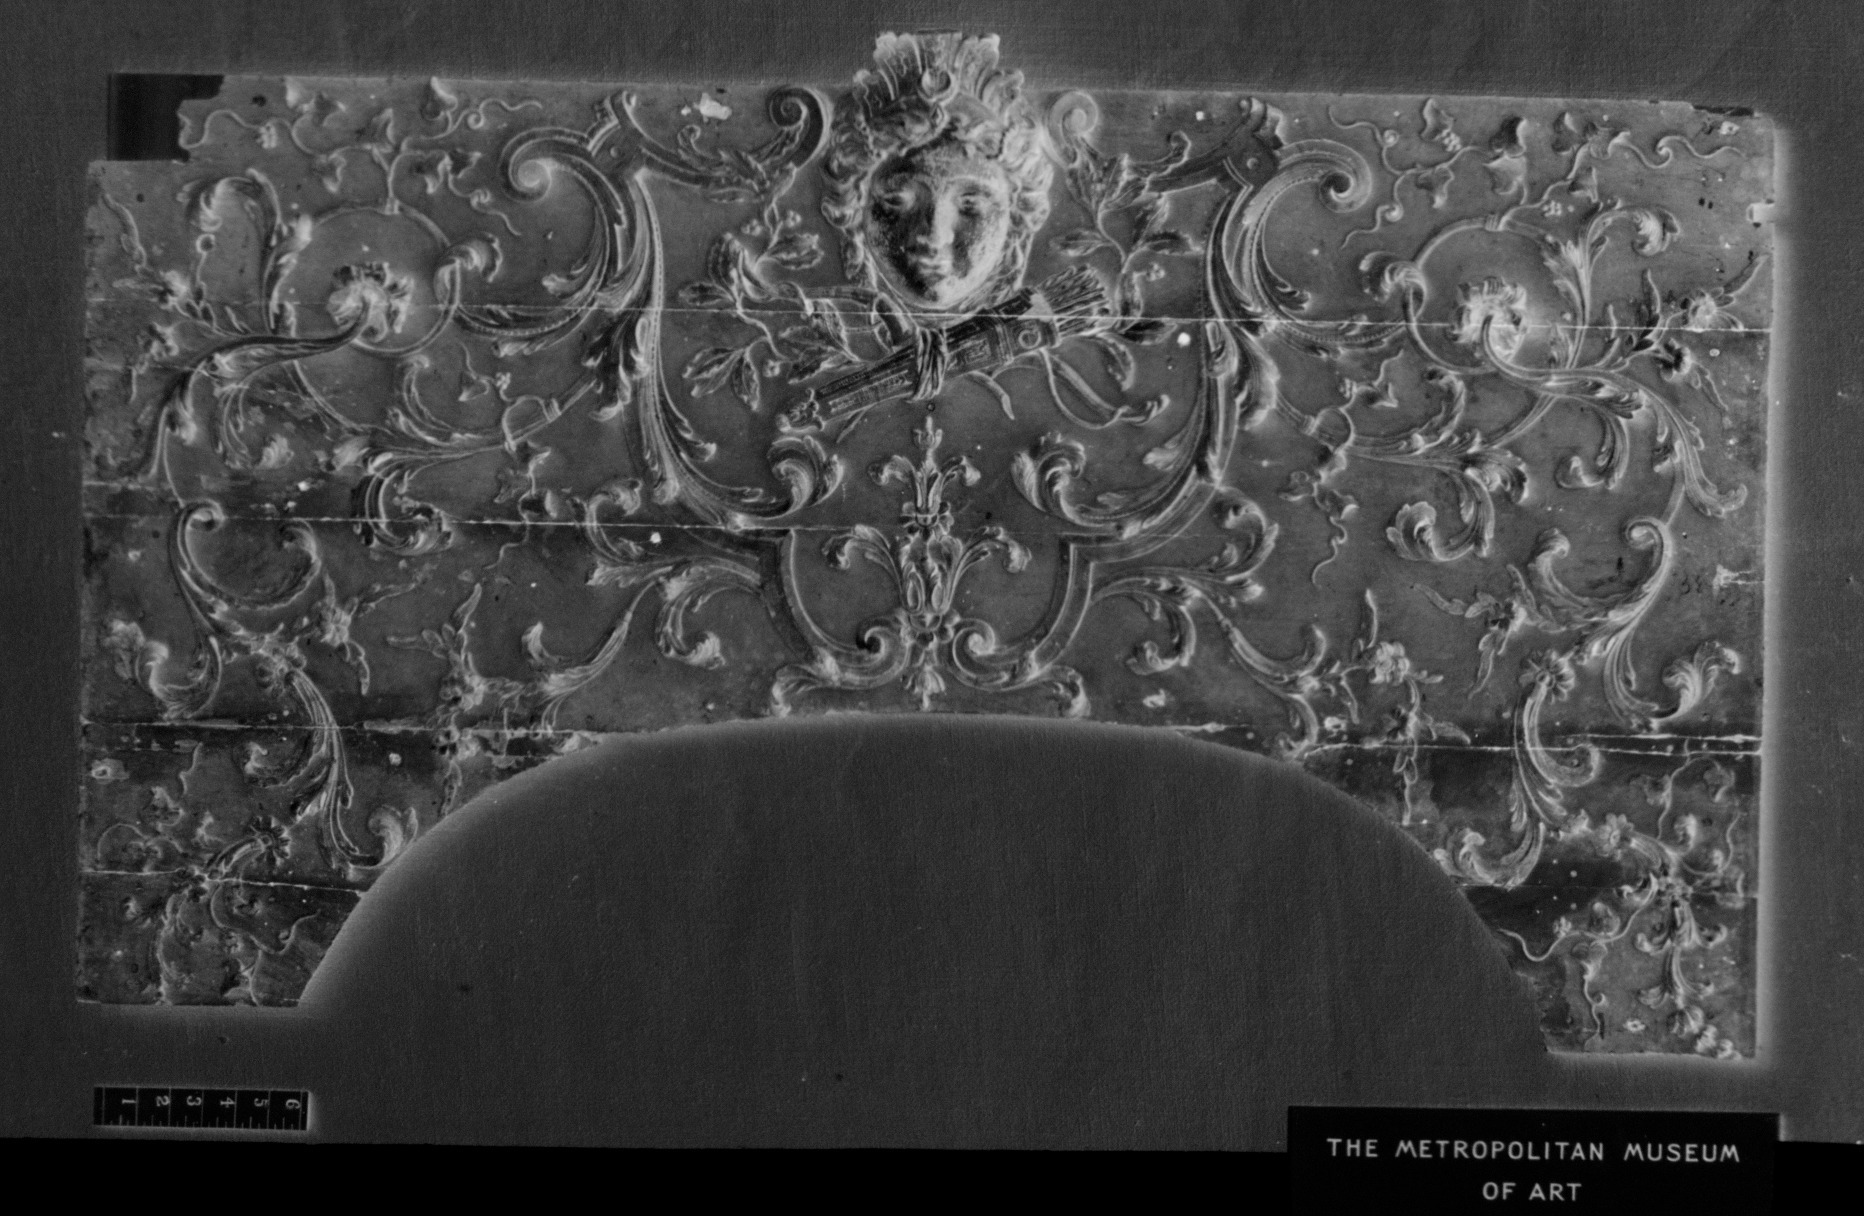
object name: mirror frame panel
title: Panel from the top of a mirror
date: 1715-1723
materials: wood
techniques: carving, gilding